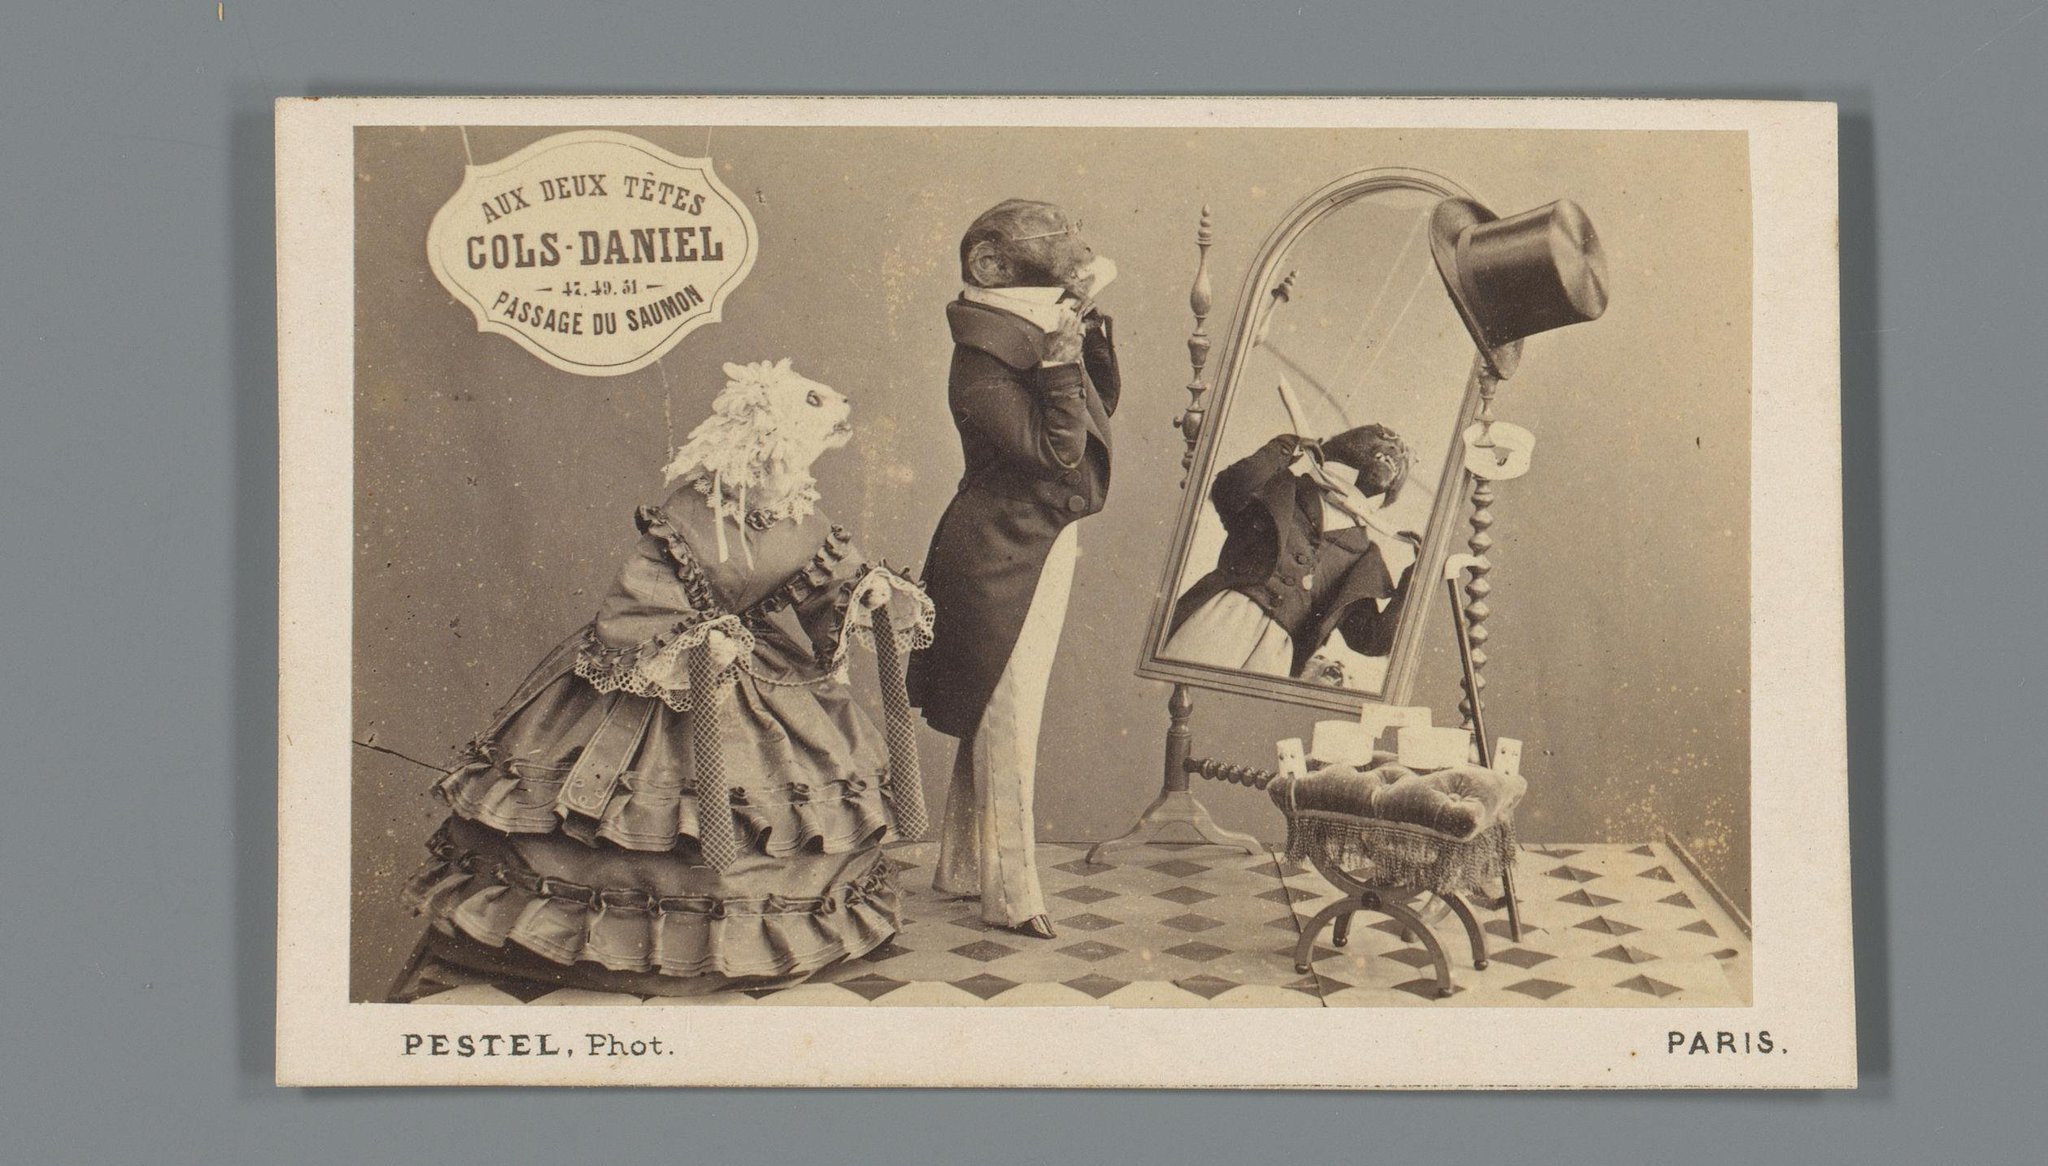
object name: carte de visite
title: Opgezette kat en aap in kleding voor een spiegel als reclame voor kledingwinkel Deux Têtes in Parijs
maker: alphonse pestel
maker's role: fotograaf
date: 1850-1915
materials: cardboard, photographic support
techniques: albumen print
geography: paris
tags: advertising, cat, monkeys, apes, clothes manufacture, clothing industry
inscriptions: inscription: ‘AUX DEUX TÊTES,/ MAISON DANIEL,/ LOISEAU Sucr./ FABRIQUE SPÉCIALE/ DE/ COLS-CRAVATES/ FAUX COLS./ Passage du Saumon,/ 47, 49, 51./ PARIS/ PORTAITS/ en tous genres/ PHOTOGRAPHIE/ DE LA/ PORTE St. DENIS/ PESTEL,/ Boult. Bonne Nouvelle, 3./ PARIS/ REPRODUCTIONS’